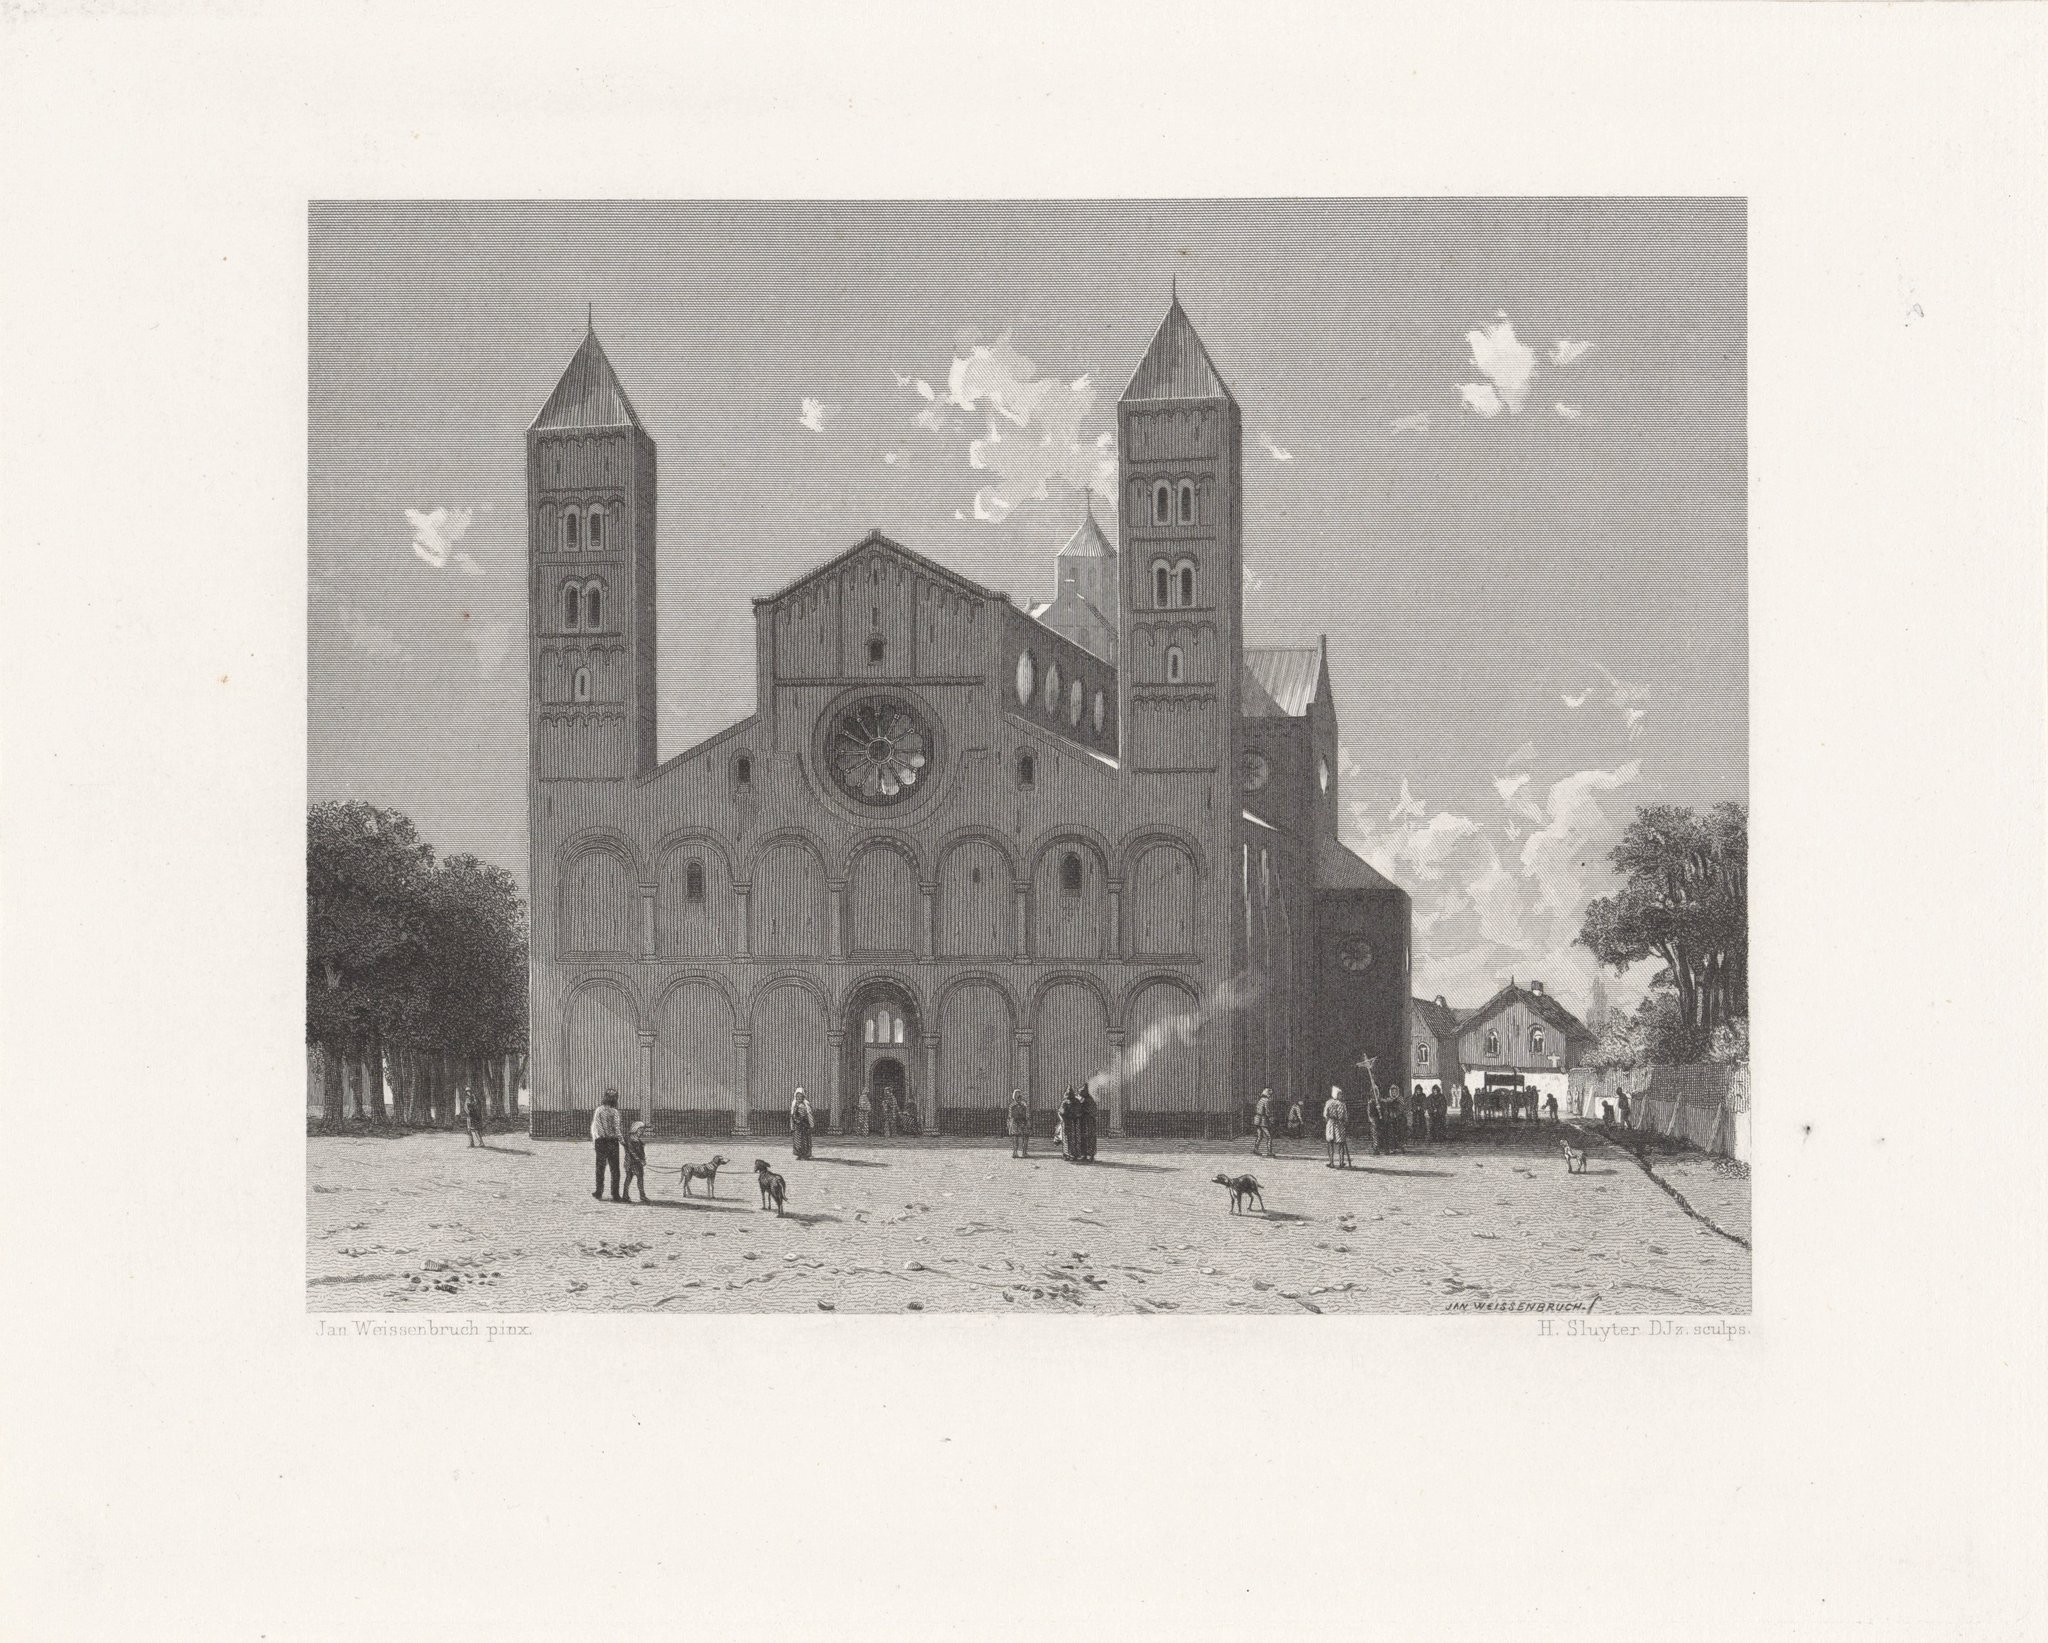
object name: print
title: Mariakerk te Utrecht, 1090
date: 1865-1870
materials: paper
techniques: engraving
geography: netherlands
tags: procession ~ christian religion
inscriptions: collector's mark: Lugt 2228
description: Illustratie voor: J. van Lennep en W. Moll en J. ter Gouw, Nederlands geschiedenis en volksleven in schetsen. Leiden: A.W. Sijthoff, [ca. 1870]. Staalgravures naar de schilderijen van de Historische Galerij der Maatschappij Arti en Amicitiae.